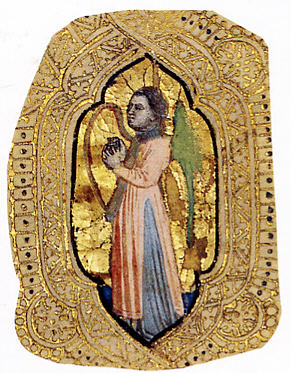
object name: manuscript and illumination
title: Angel with Harp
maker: cristoforo cortese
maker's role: artist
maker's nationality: italian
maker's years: 1385-1445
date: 1401-1407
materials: gold, parchment, paint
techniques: filigree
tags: harps,angels